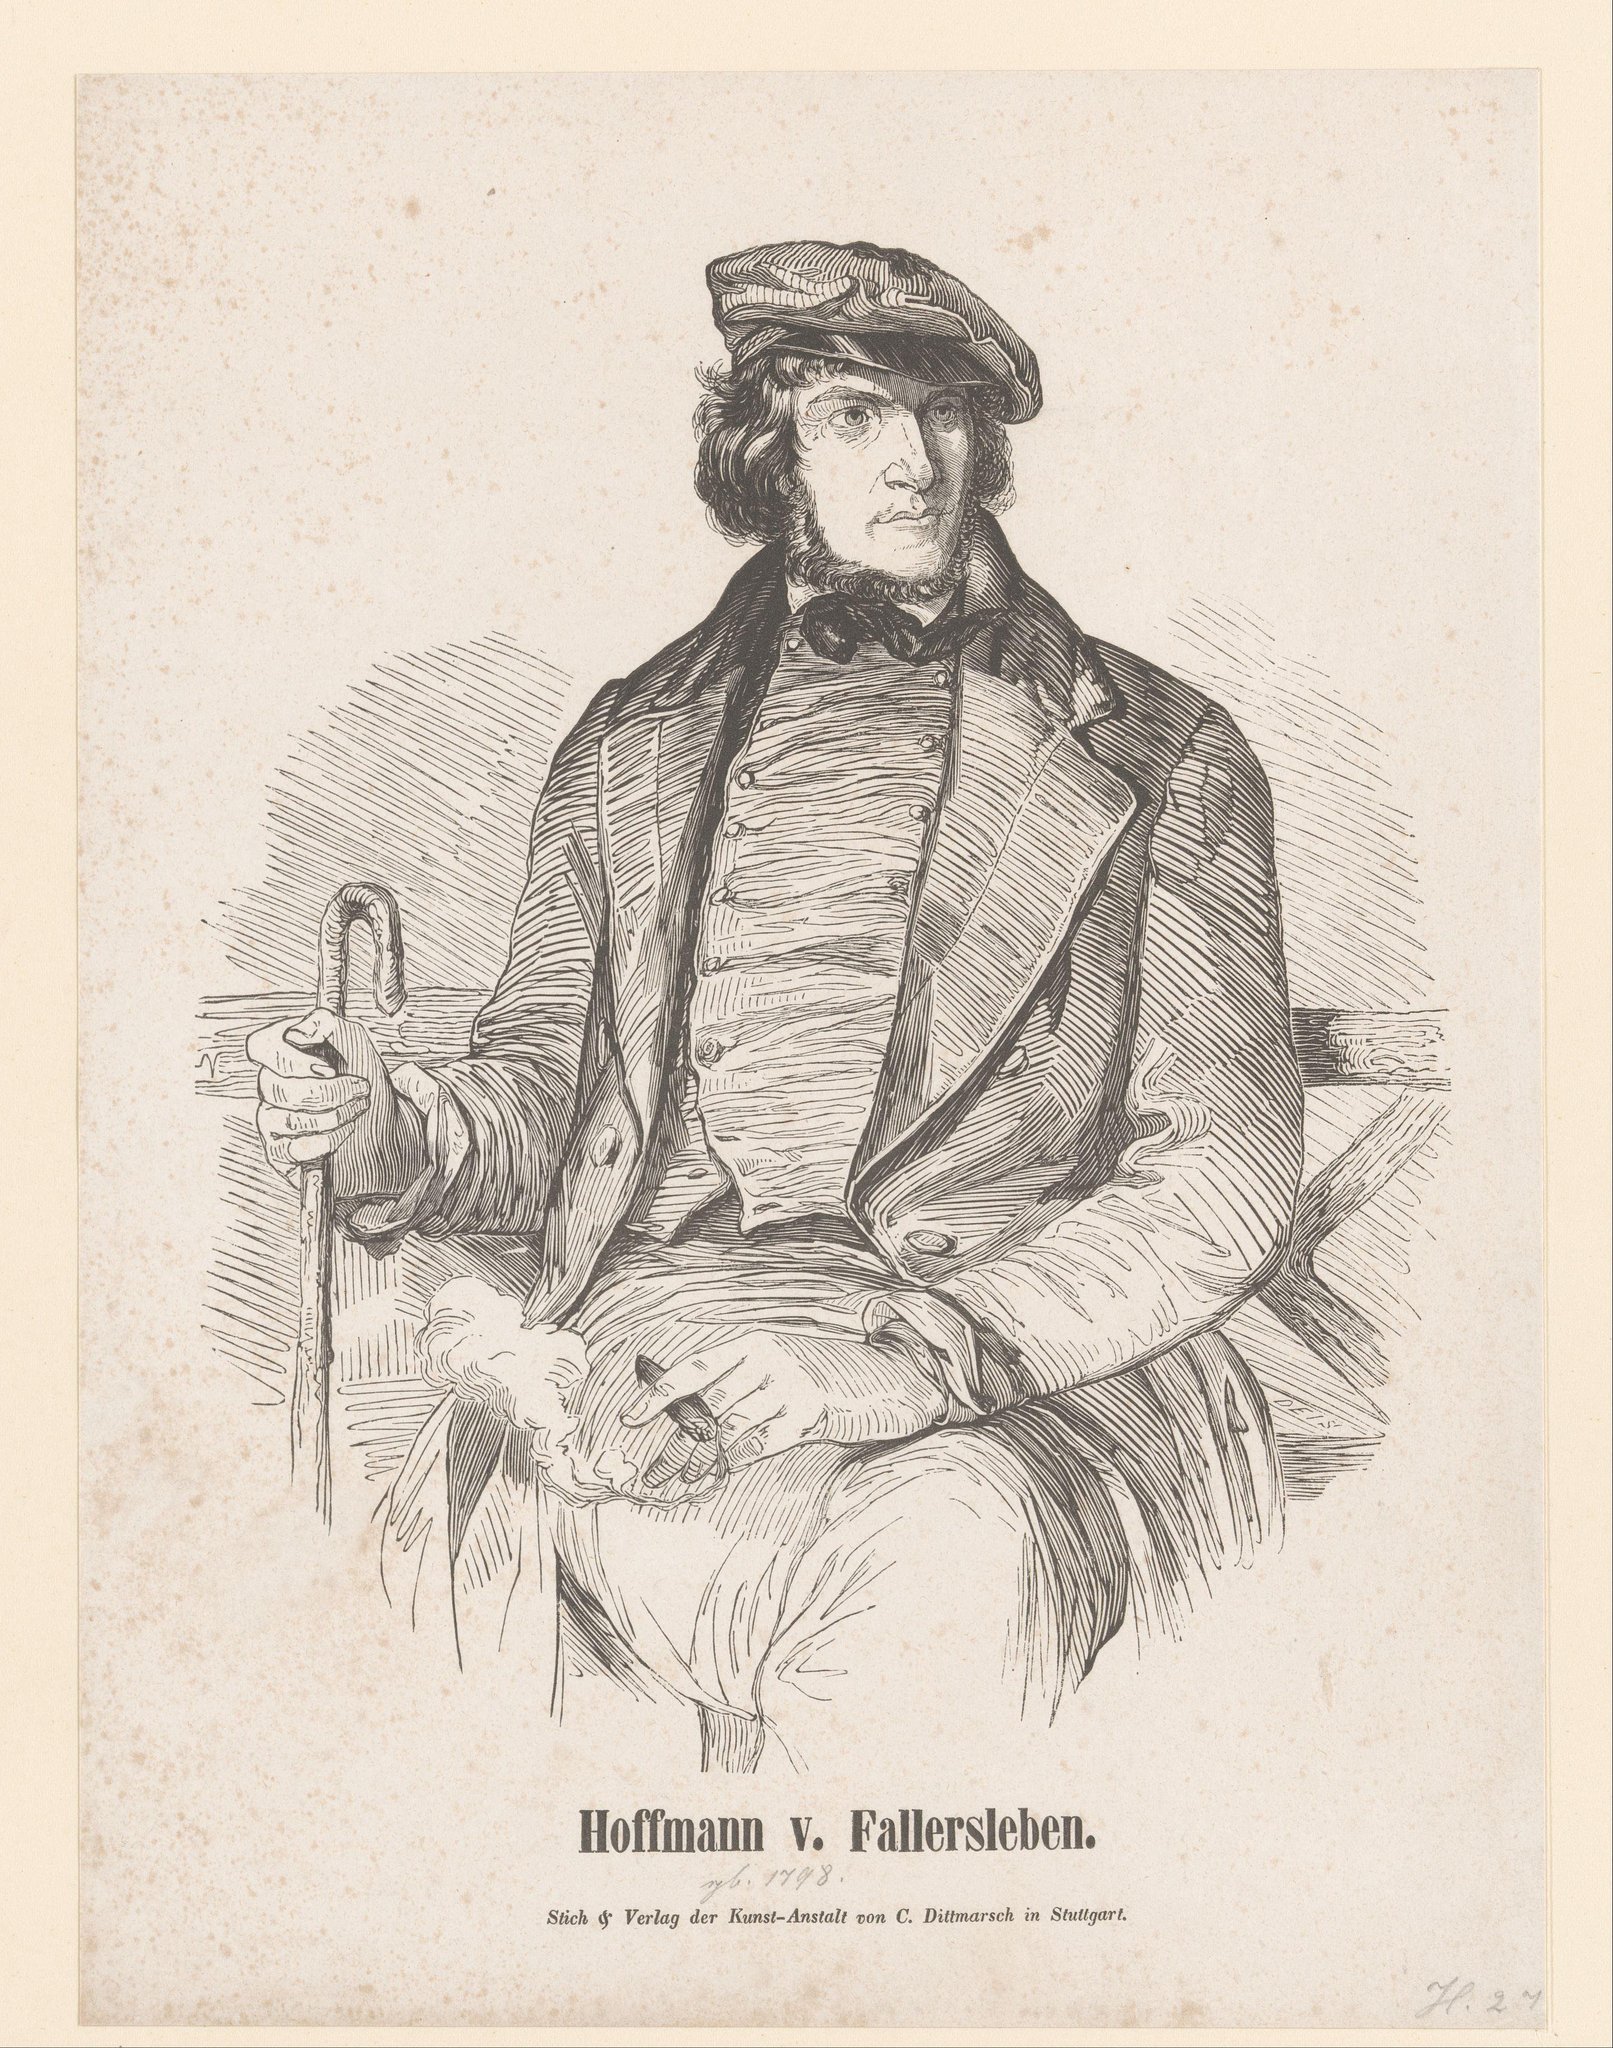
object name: print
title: Portret van August Heinrich Hoffmann von Fallersleben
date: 1824-1899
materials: paper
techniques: engraving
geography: stuttgart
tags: historical persons, writer, poet, author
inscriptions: collector's mark: Lugt 2228